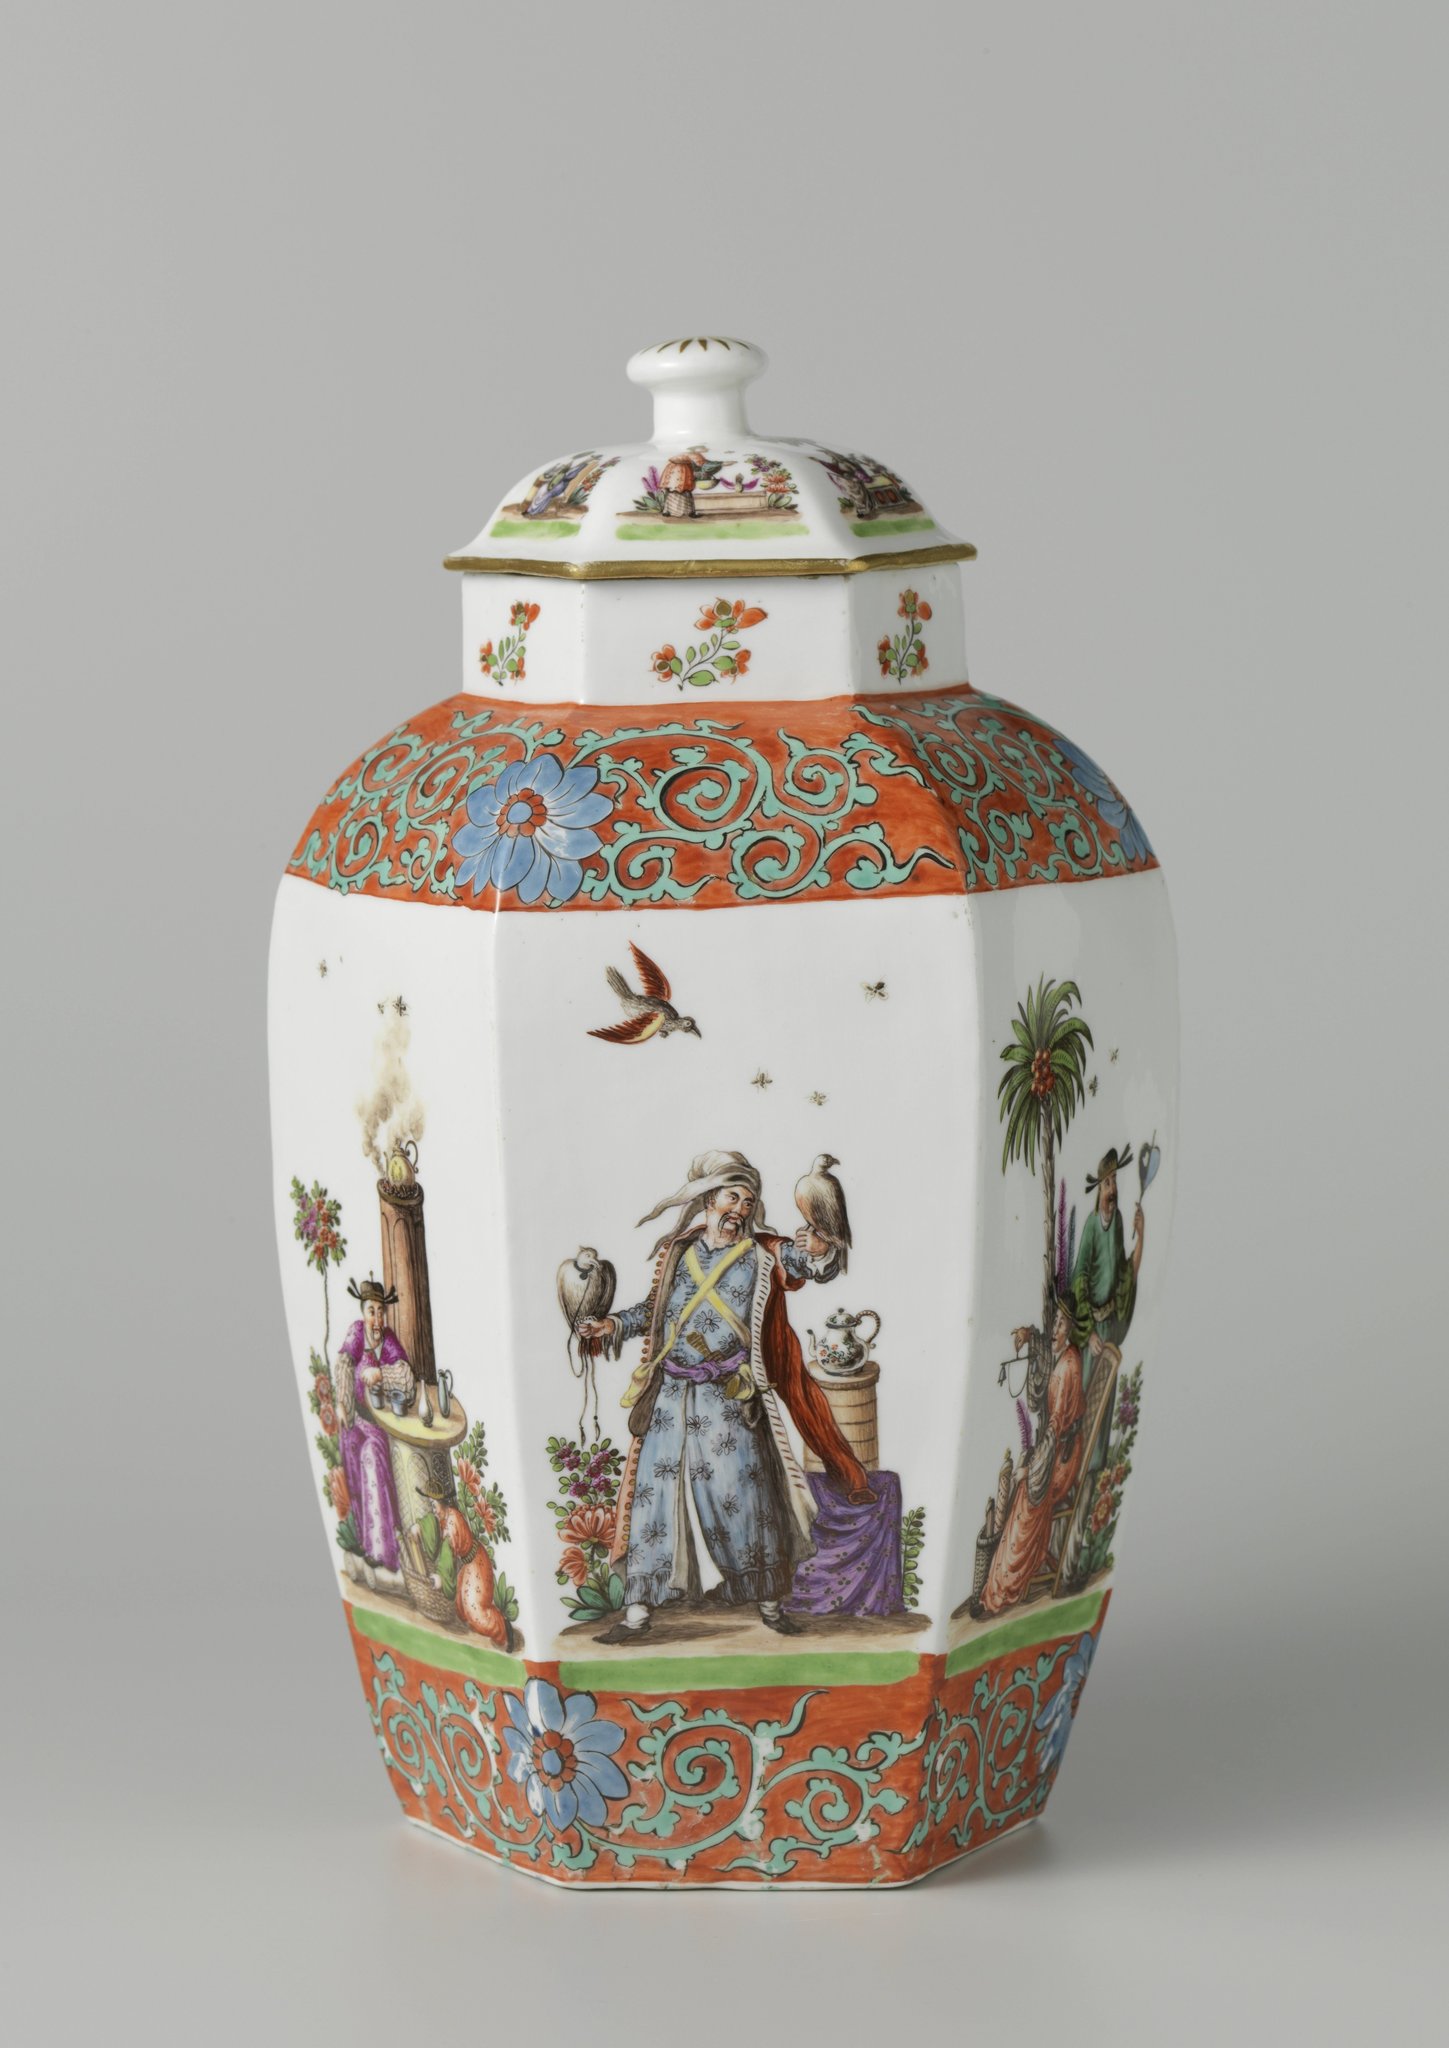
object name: decoratief object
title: Two lidded vases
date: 1730-1735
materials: porcelain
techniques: painted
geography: meissen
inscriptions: number: ‘181’, factory mark: ‘AR’, number: ‘184.’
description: Meissener Porzellan Manufaktur after prints by Charles François Silvestre (1667–1738) Meissen, c. 1730–1735 hard-paste porcelain